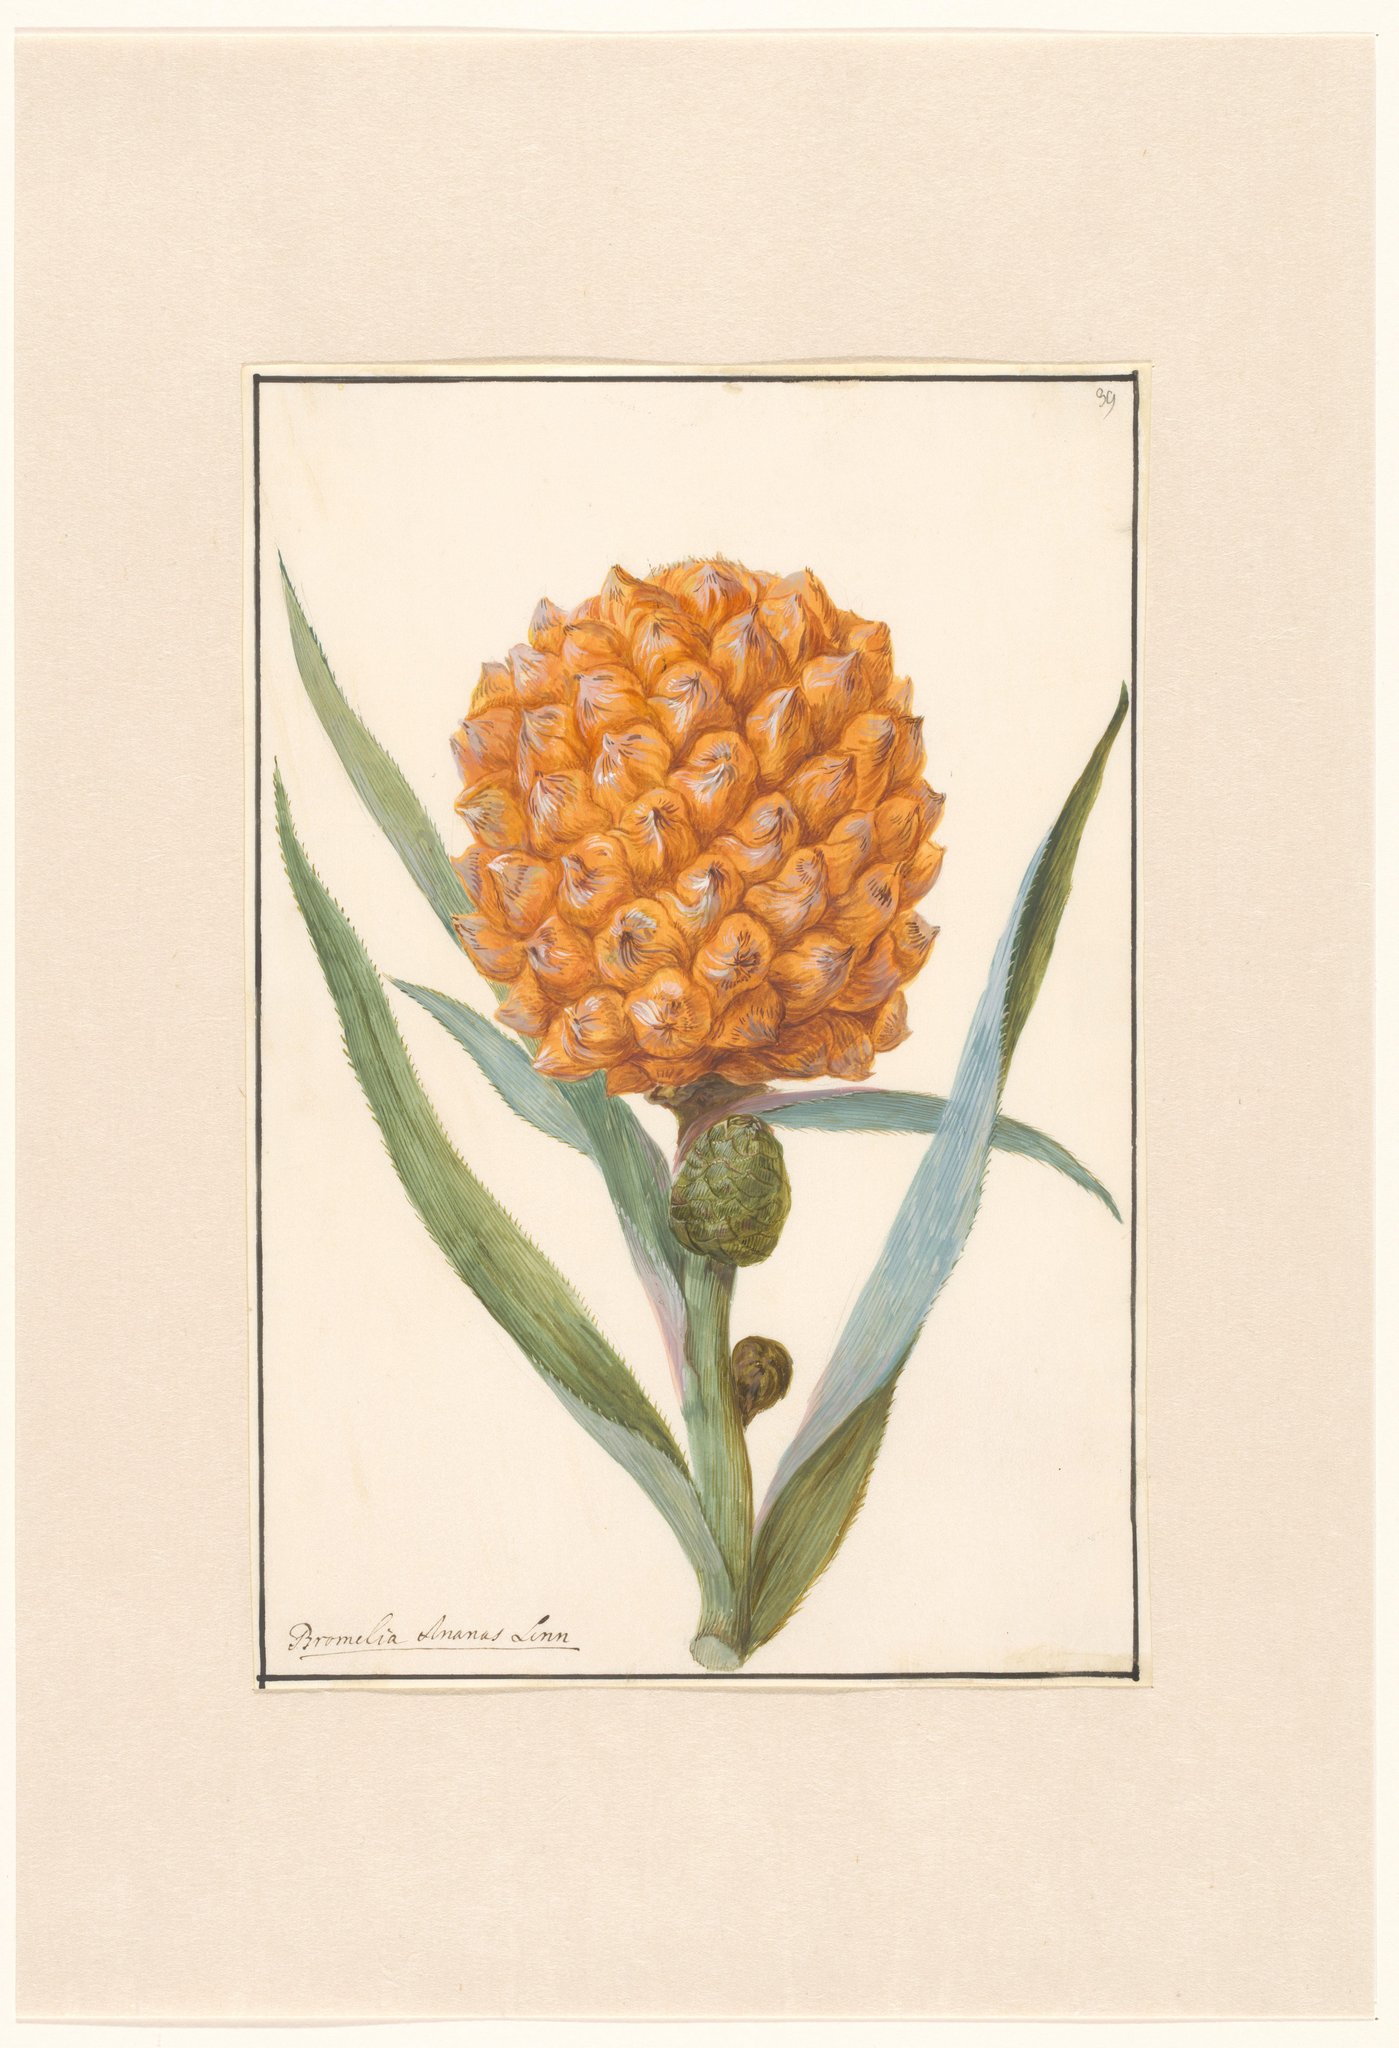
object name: drawing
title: Ananas op tak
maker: Anonymous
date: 1700-1749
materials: gouache, parchment, pencil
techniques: brush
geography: netherlands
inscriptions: inscription: ‘39’, annotation: ‘Bromelia Ananas Linn’